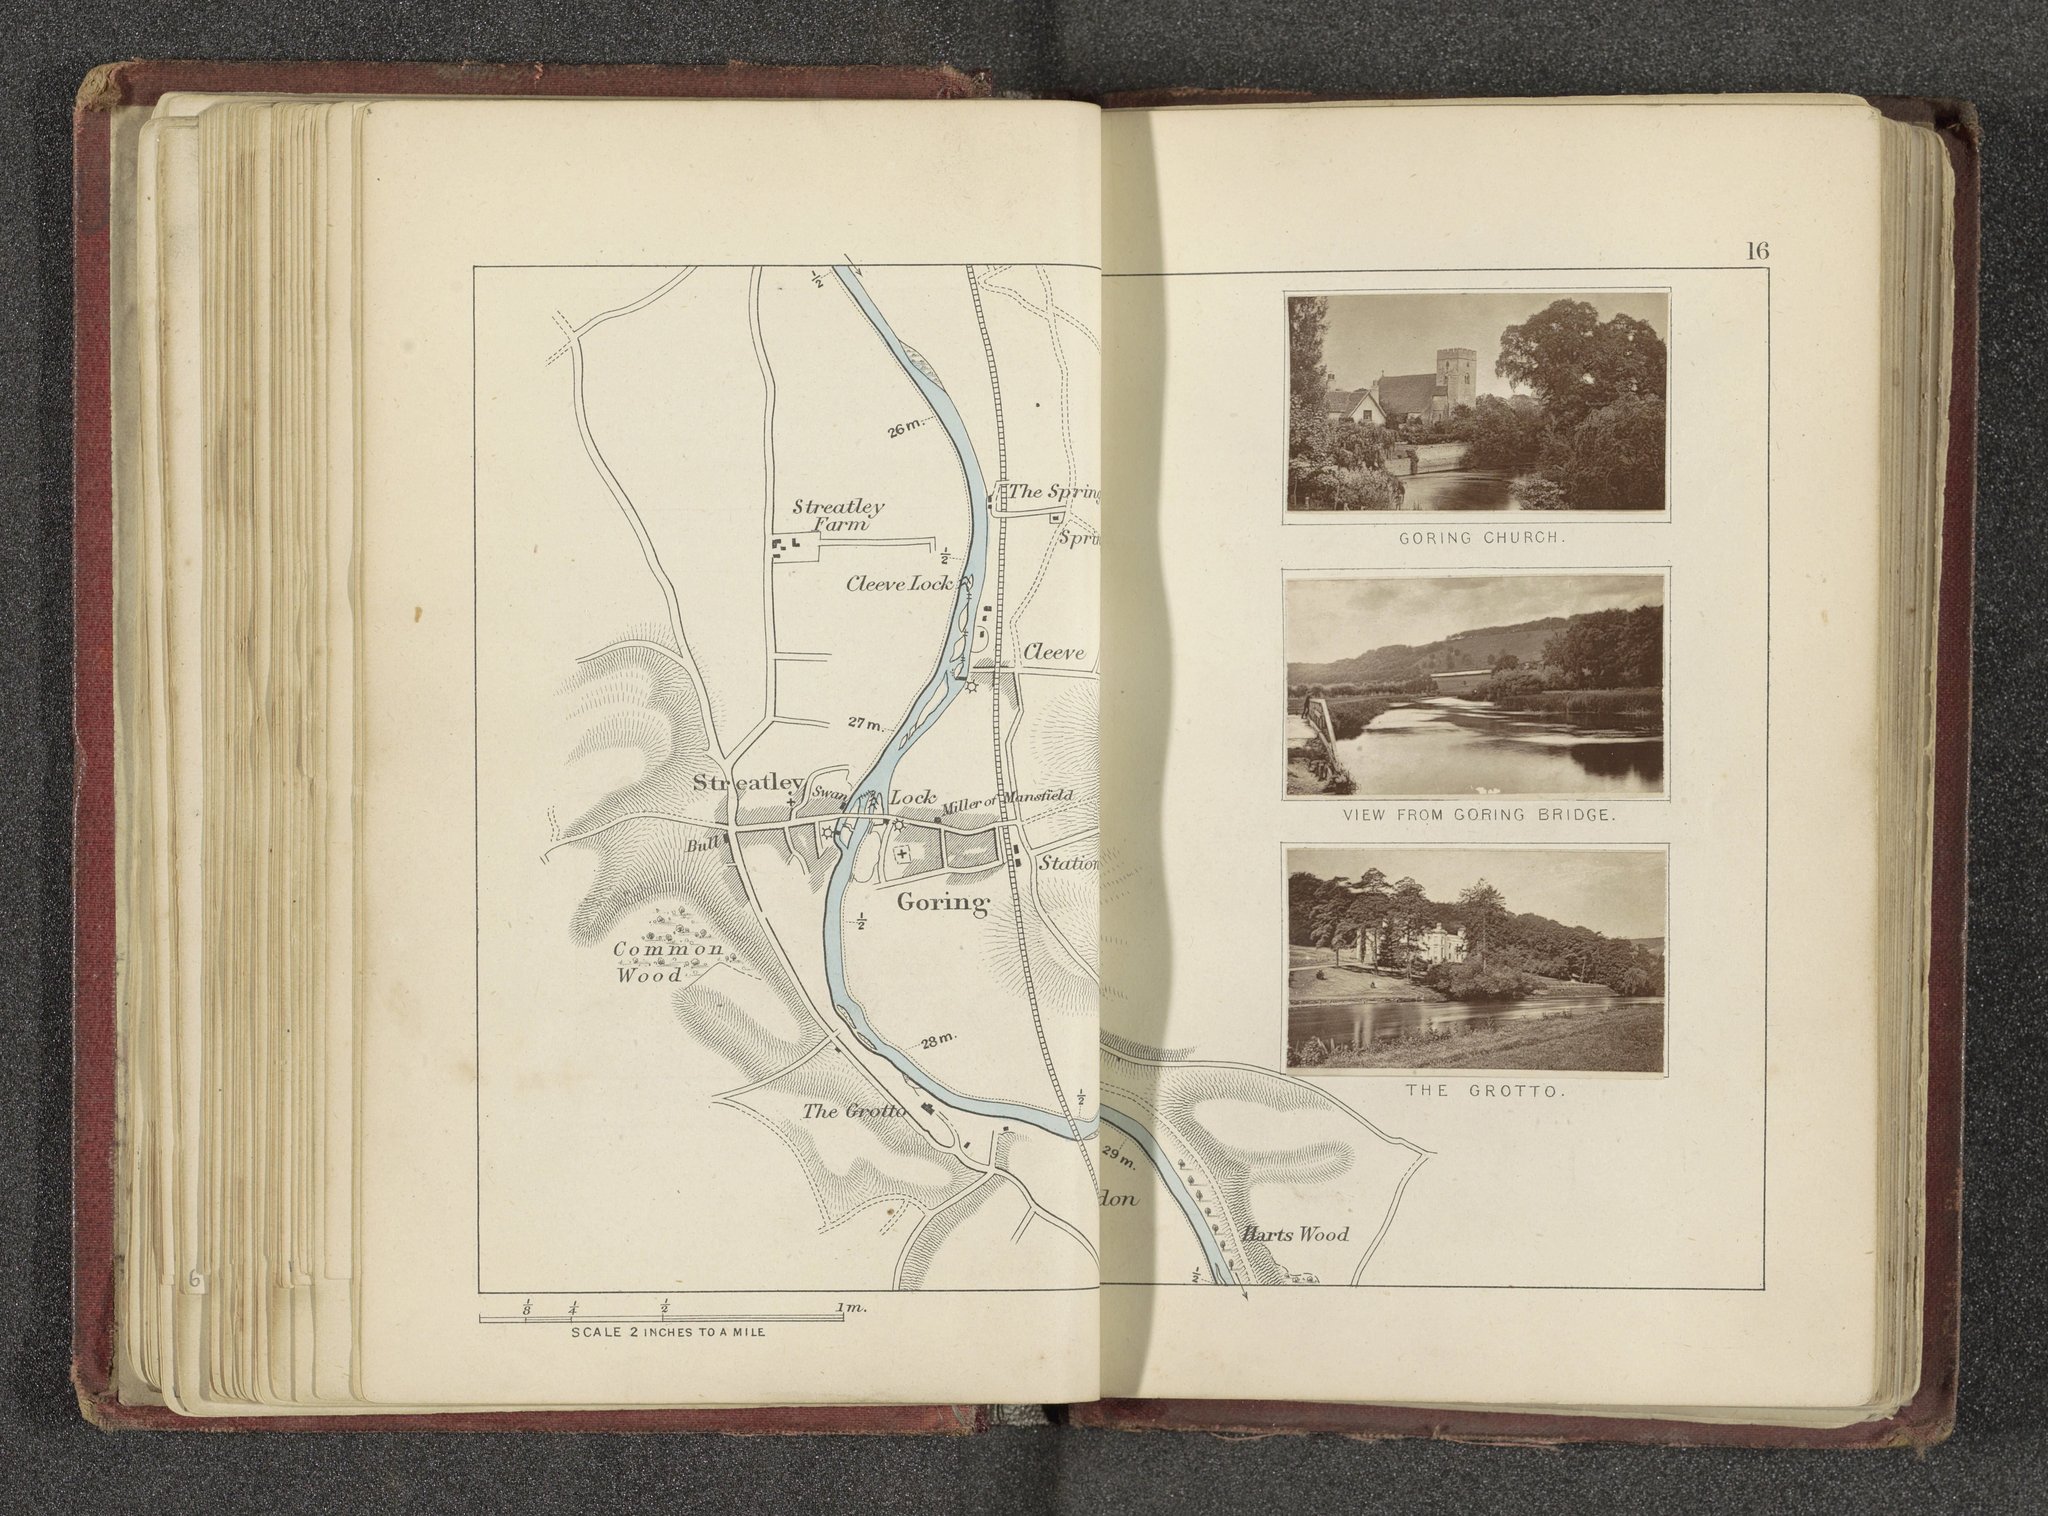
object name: print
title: Kaart met drie afbeeldingen van plaatsen langs de Theems bij Goring-on-Thames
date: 1878-1879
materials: paper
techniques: engraving, woodburytype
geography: goring-on-thames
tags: city-view, and landscape with man-made constructions, architectural folly, river, bridge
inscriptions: inscription: ‘Goring church. View from Goring bridge. The grotto.’, number: ‘16’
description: Boven: gezicht op de kerk, midden: gezicht op een brug, onder: gezicht op een folly in een park.